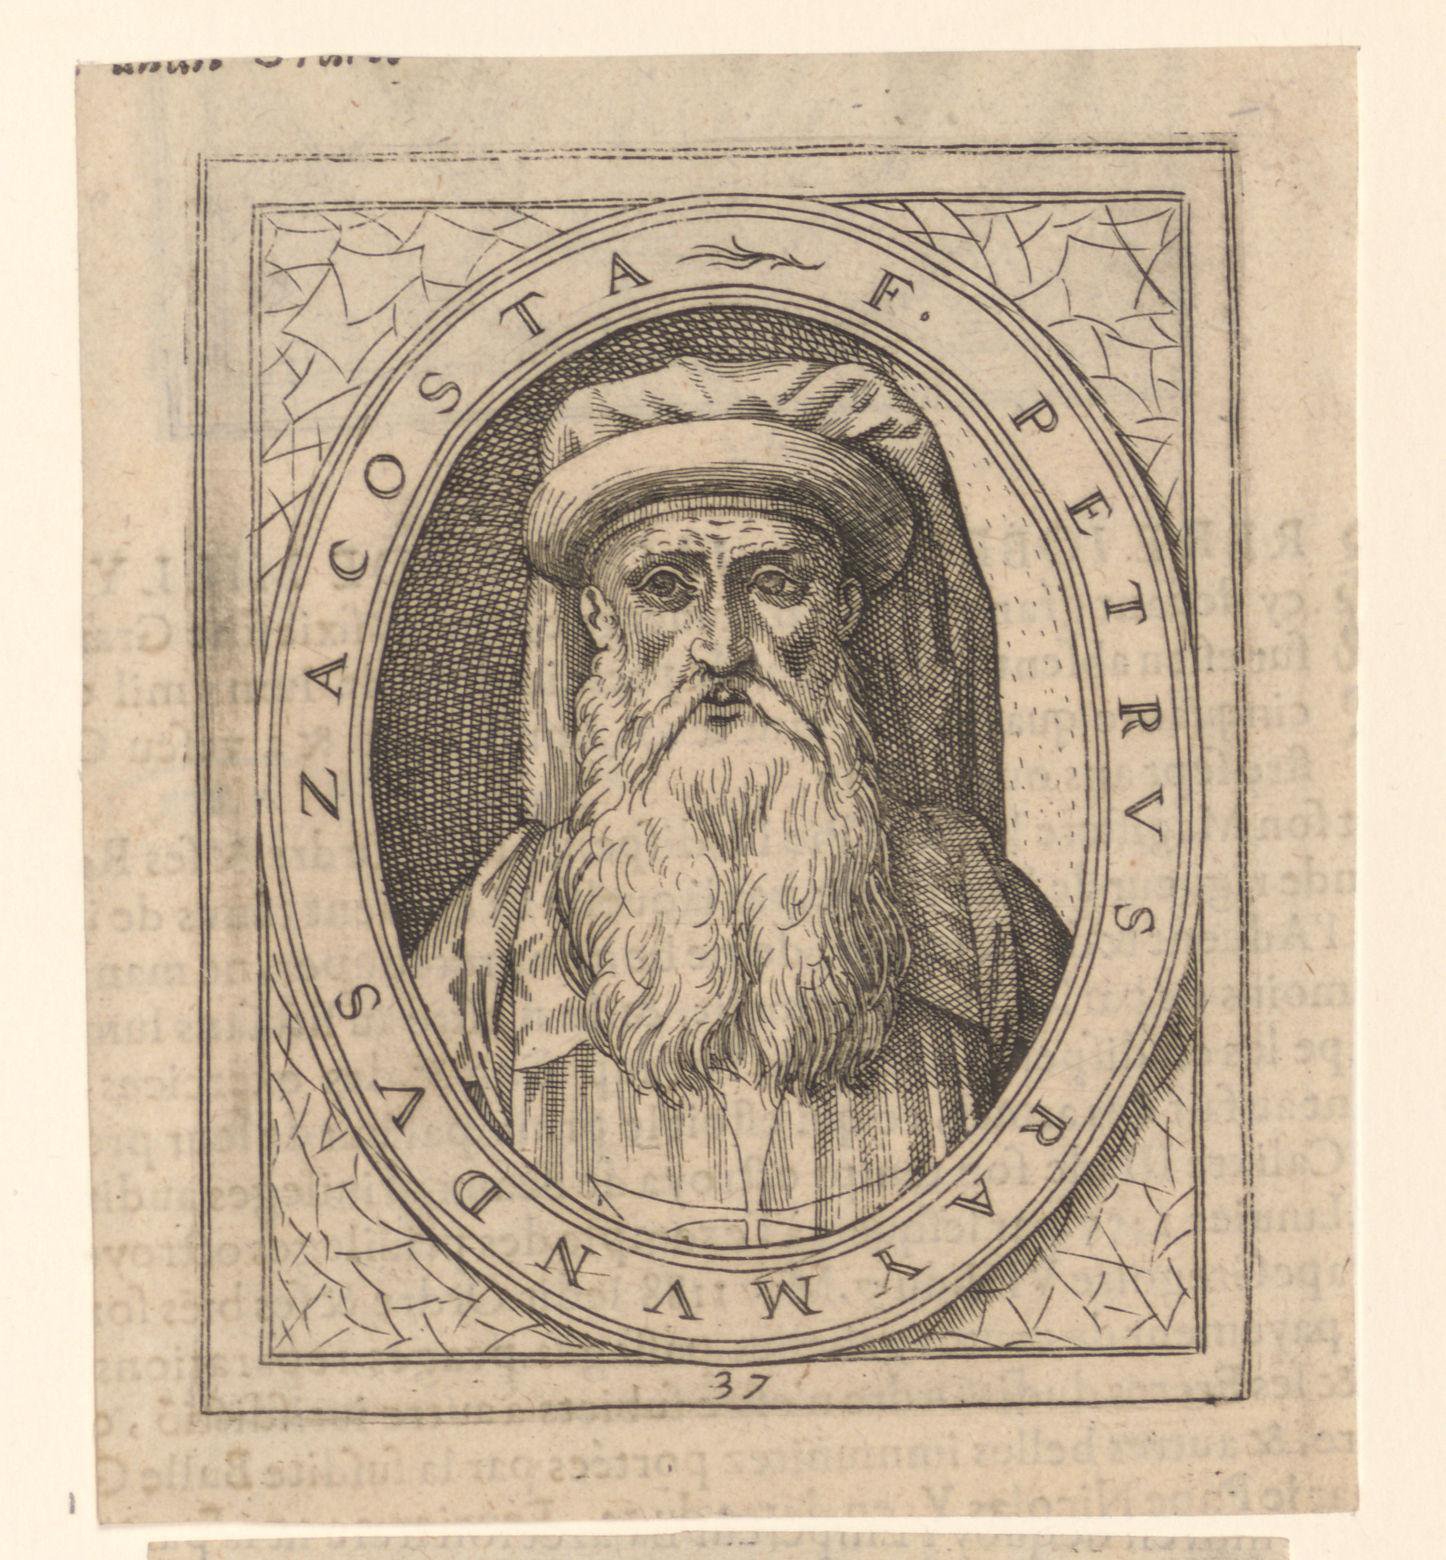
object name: print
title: Portret van Piero Raimondo Zacosta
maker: Anonymous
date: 1643-1659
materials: paper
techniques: engraving, letterpress printing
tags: historical persons, military orders, e.g.: knights templars, knights of malta, teutonic knights ~ roman catholic church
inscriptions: collector's mark: Lugt 2228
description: Prent mogelijk uit: Baudoin, Jean. Histoire des chevaliers de l'ordre de s. Jean de Hierusalem (...). Parijs: Jacques Dallin, 1643. Of uit: Baudoin, Jean. Histoire des chevaliers de l'ordre de s. Jean de Hierusalem (...). Parijs: Thomas Jolly, 1659.